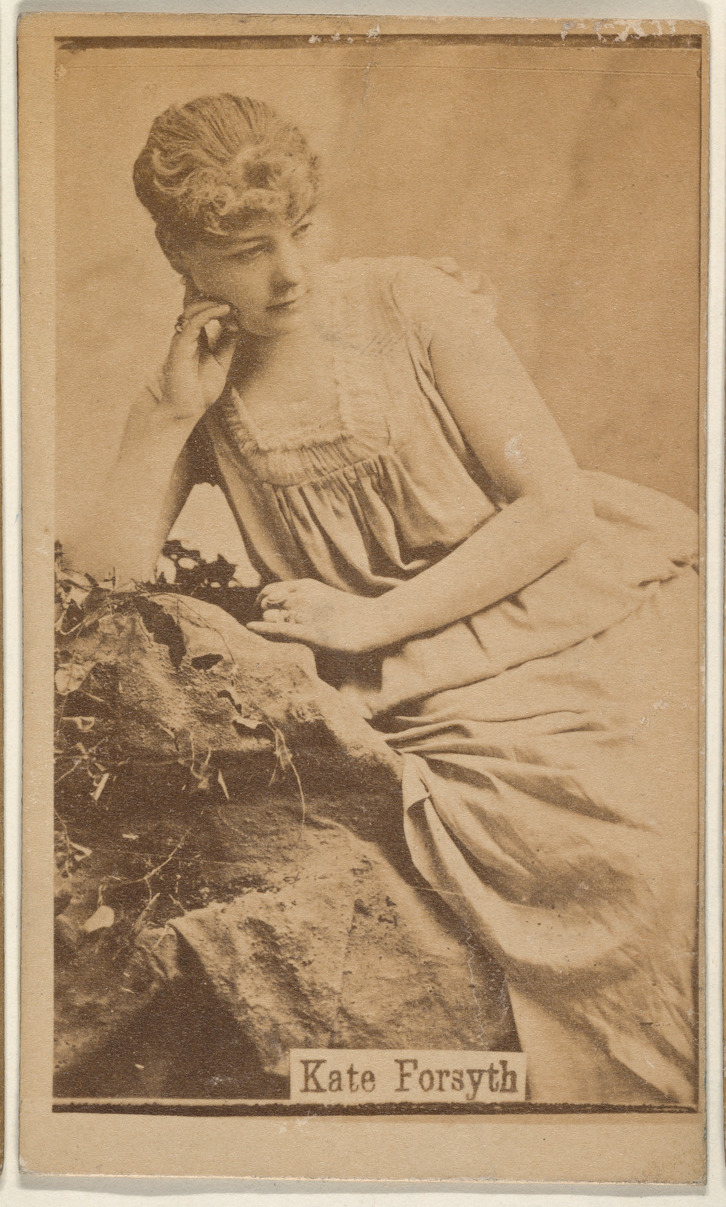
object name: photograph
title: Kate Forsyth, from the Actresses series (N668)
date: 1888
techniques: albumen silver print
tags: portraits,women,actresses